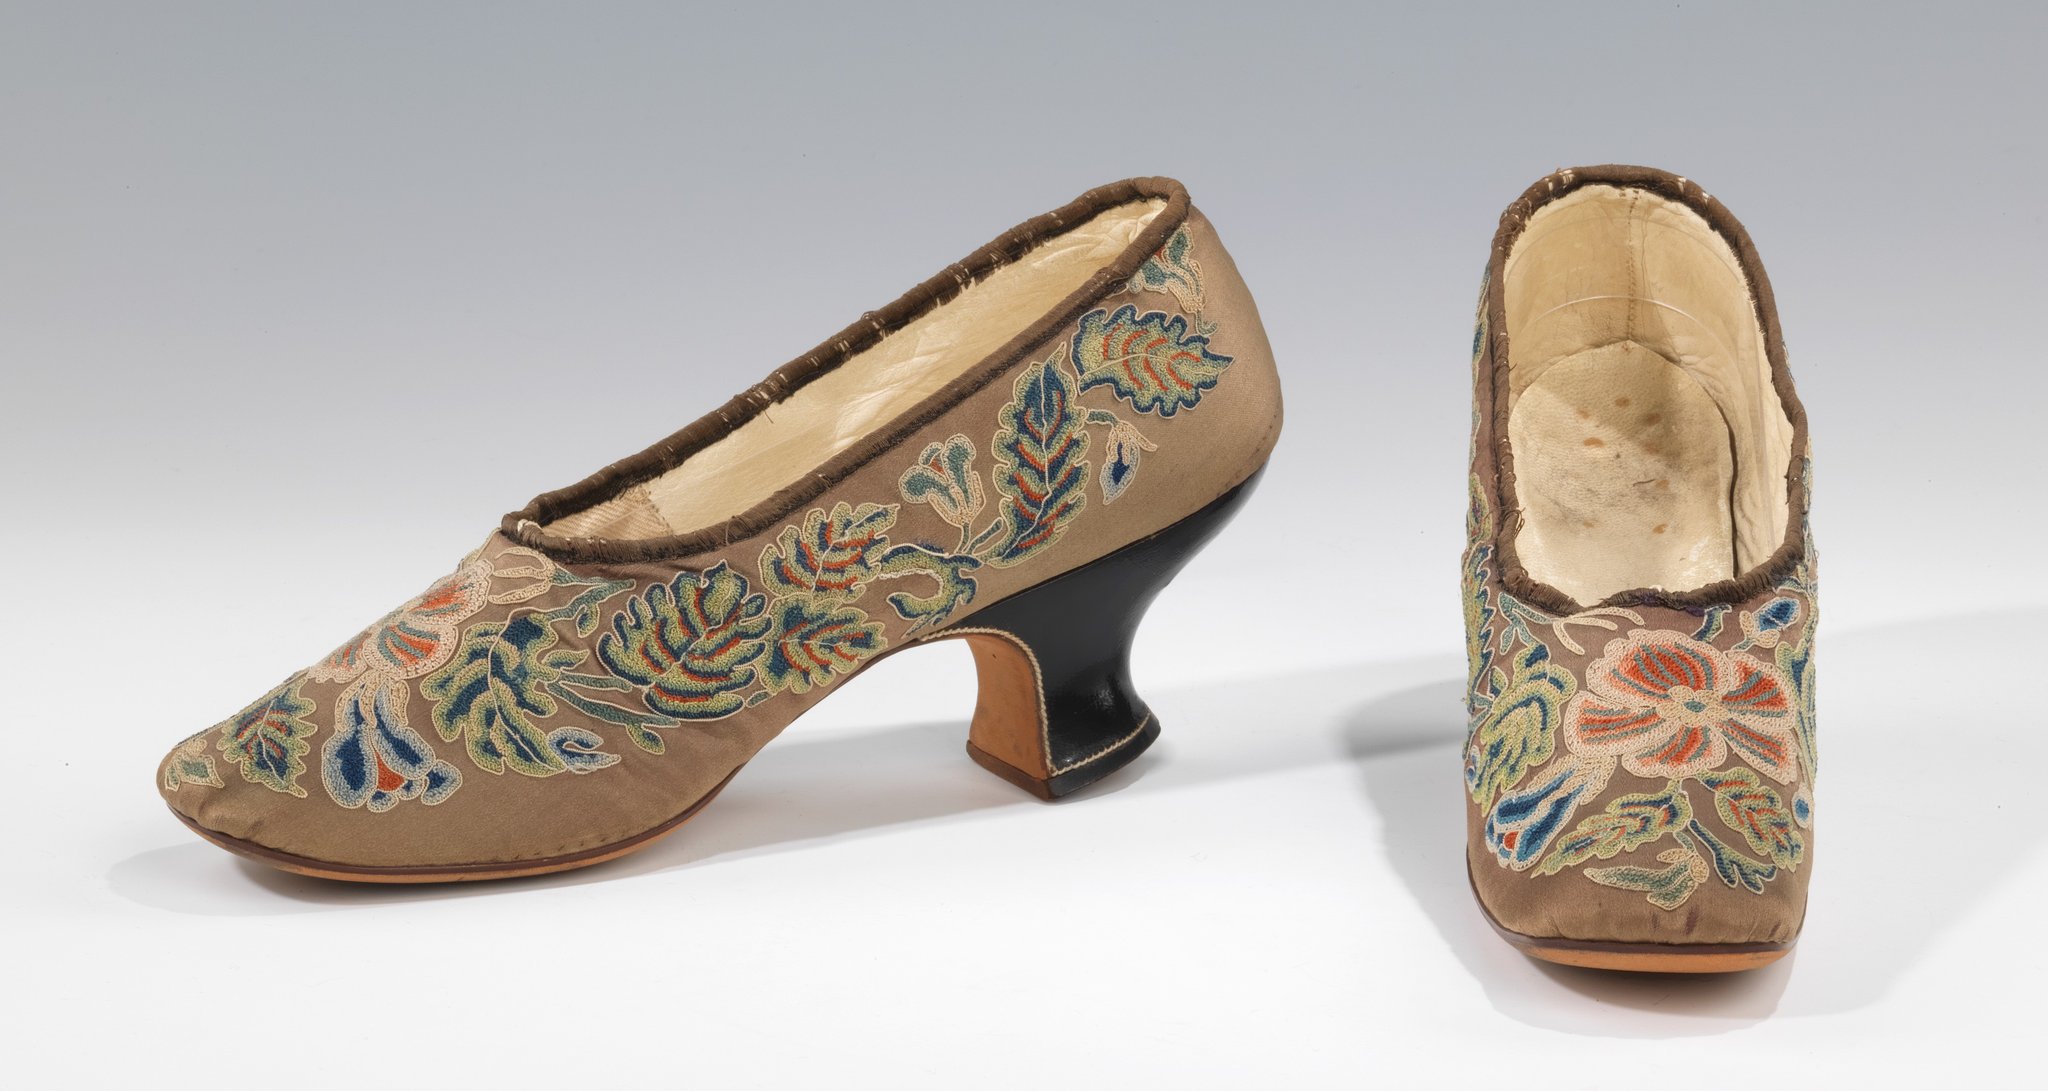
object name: slipper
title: Slippers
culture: french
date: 1885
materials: leather, silk